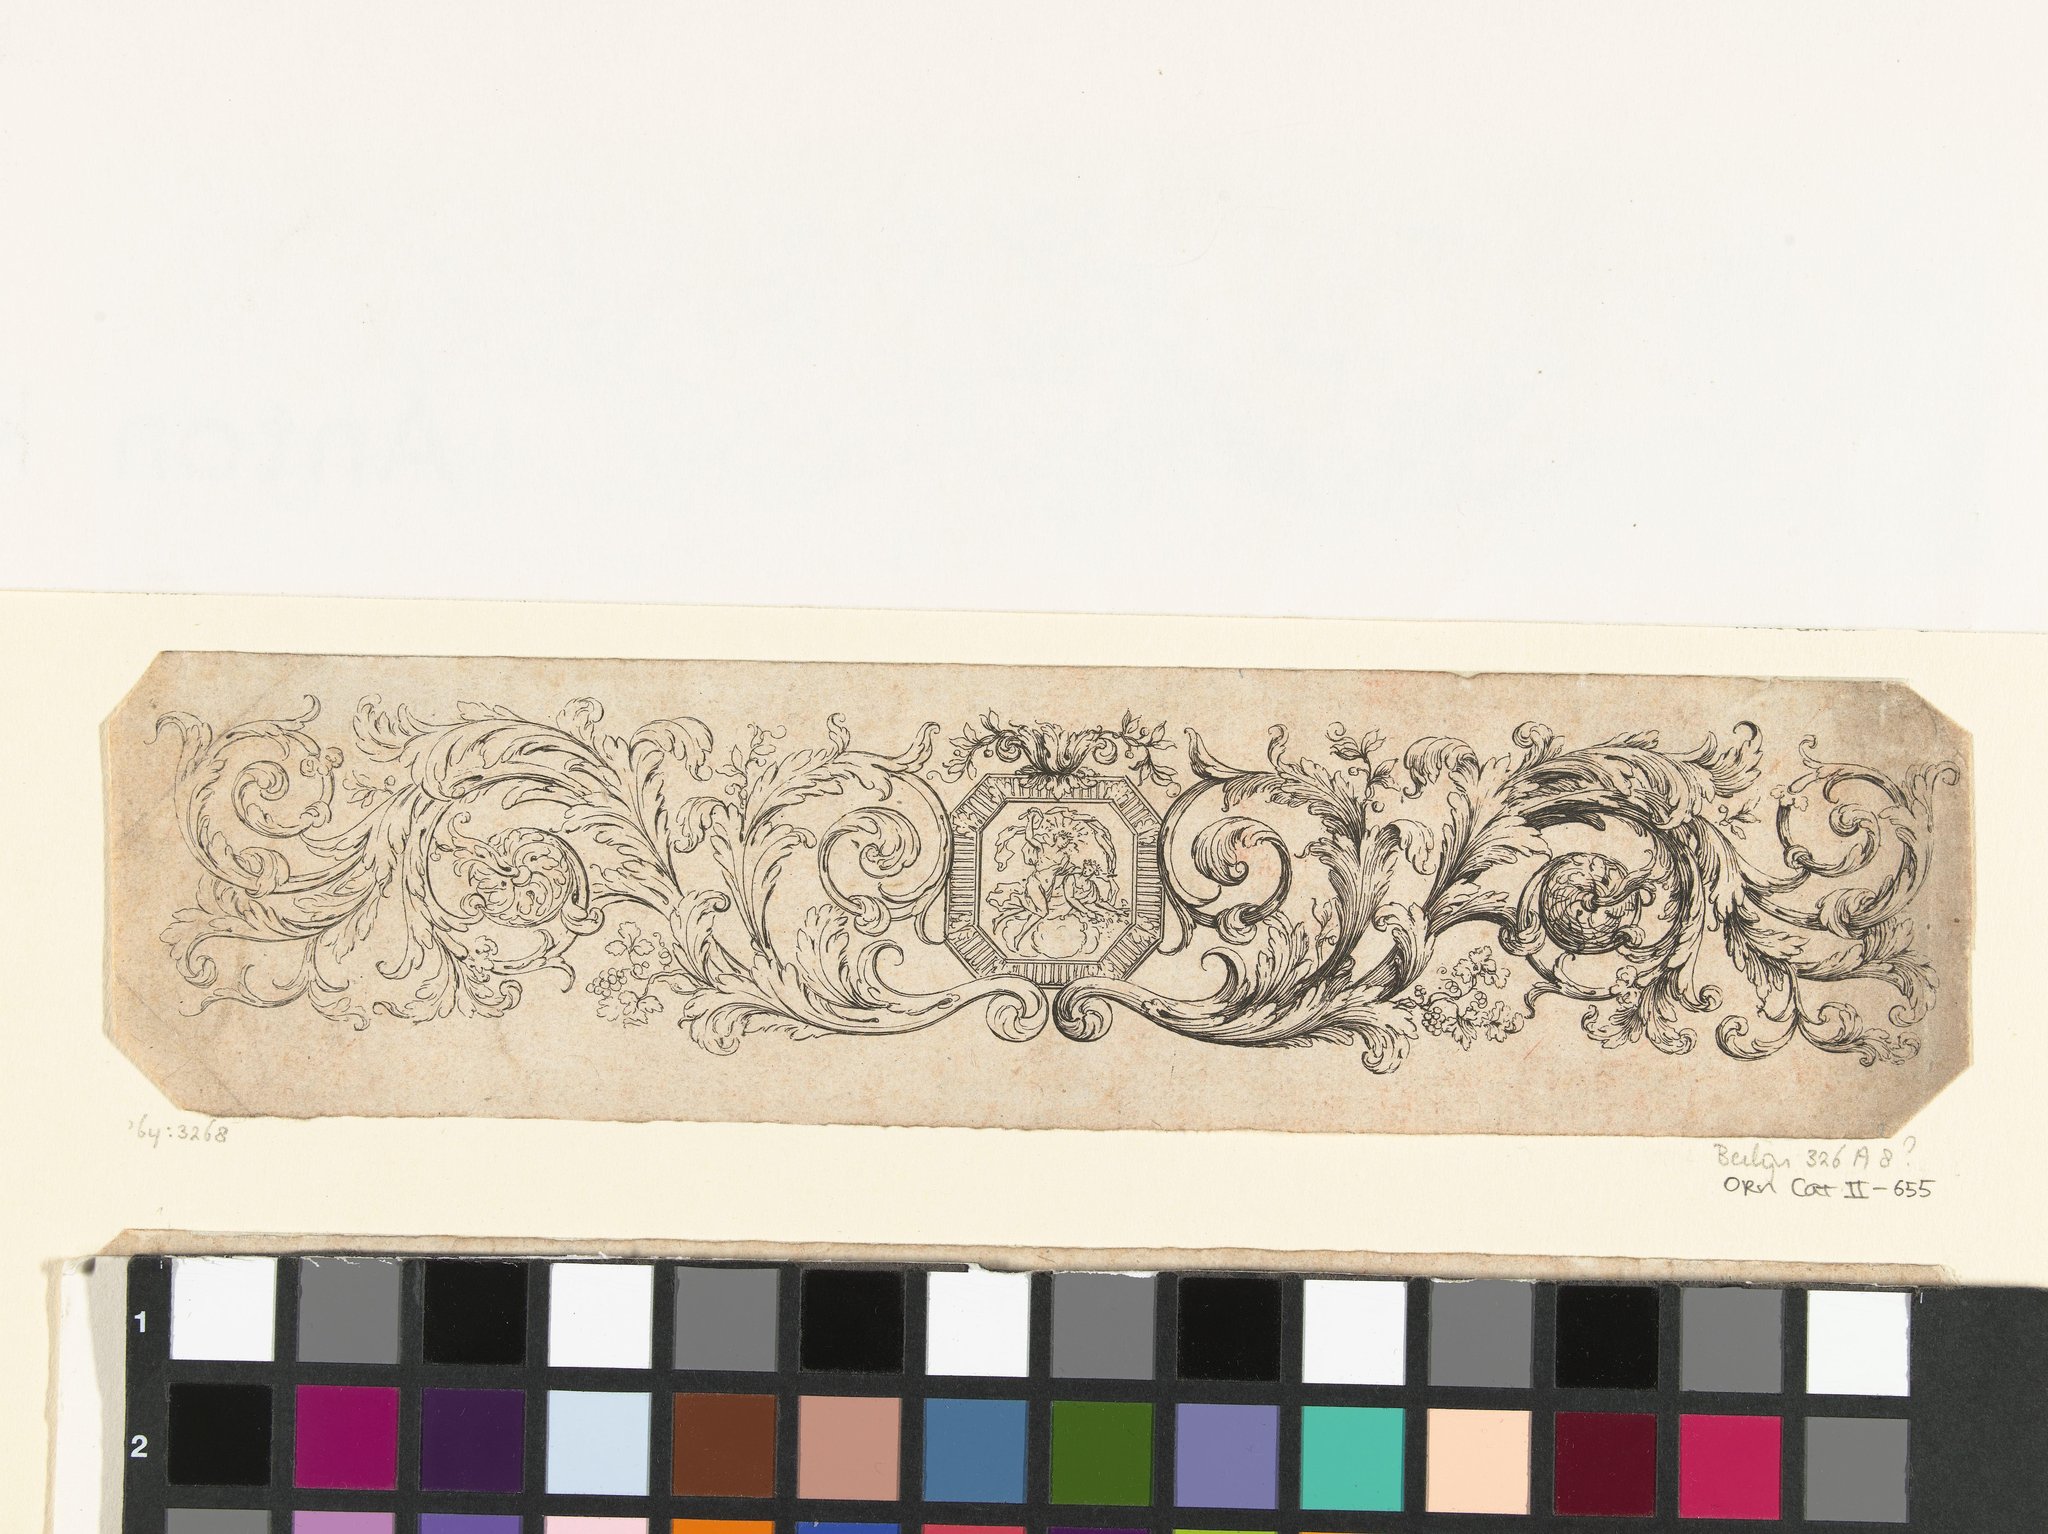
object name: print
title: Twee bladranken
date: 1670-1693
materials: paper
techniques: etching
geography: france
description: In het midden een achthoekig medaillon met twee goden.